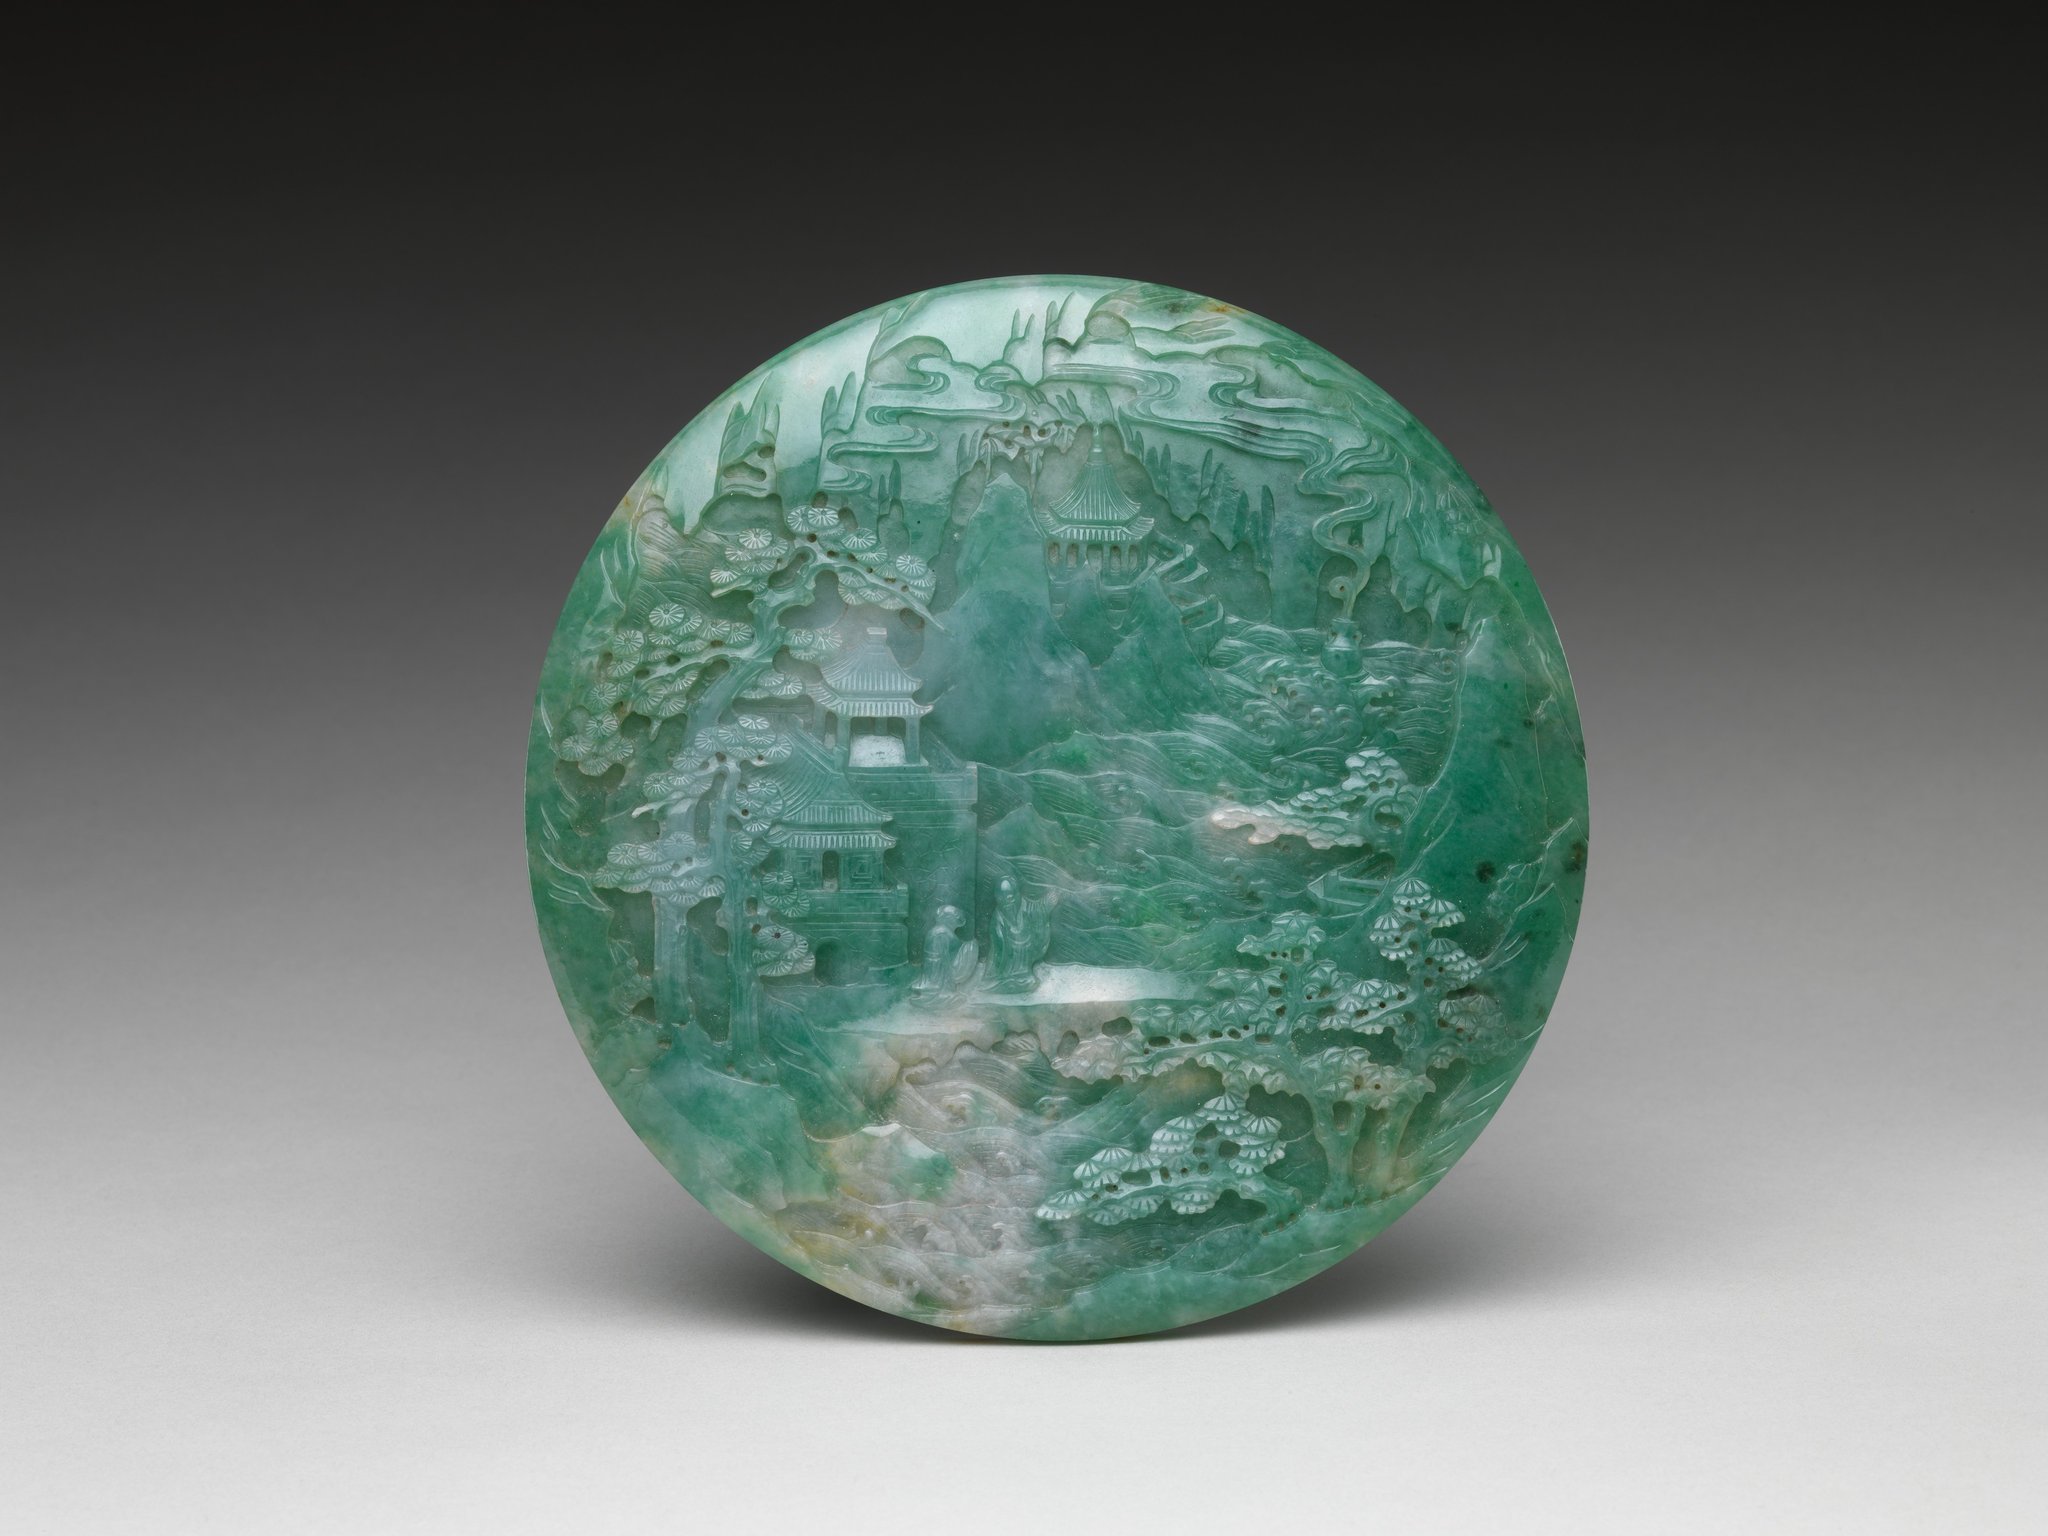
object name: table screen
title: Table screen with landscape scene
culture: chinese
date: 1701-1900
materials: jade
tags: buildings,landscapes